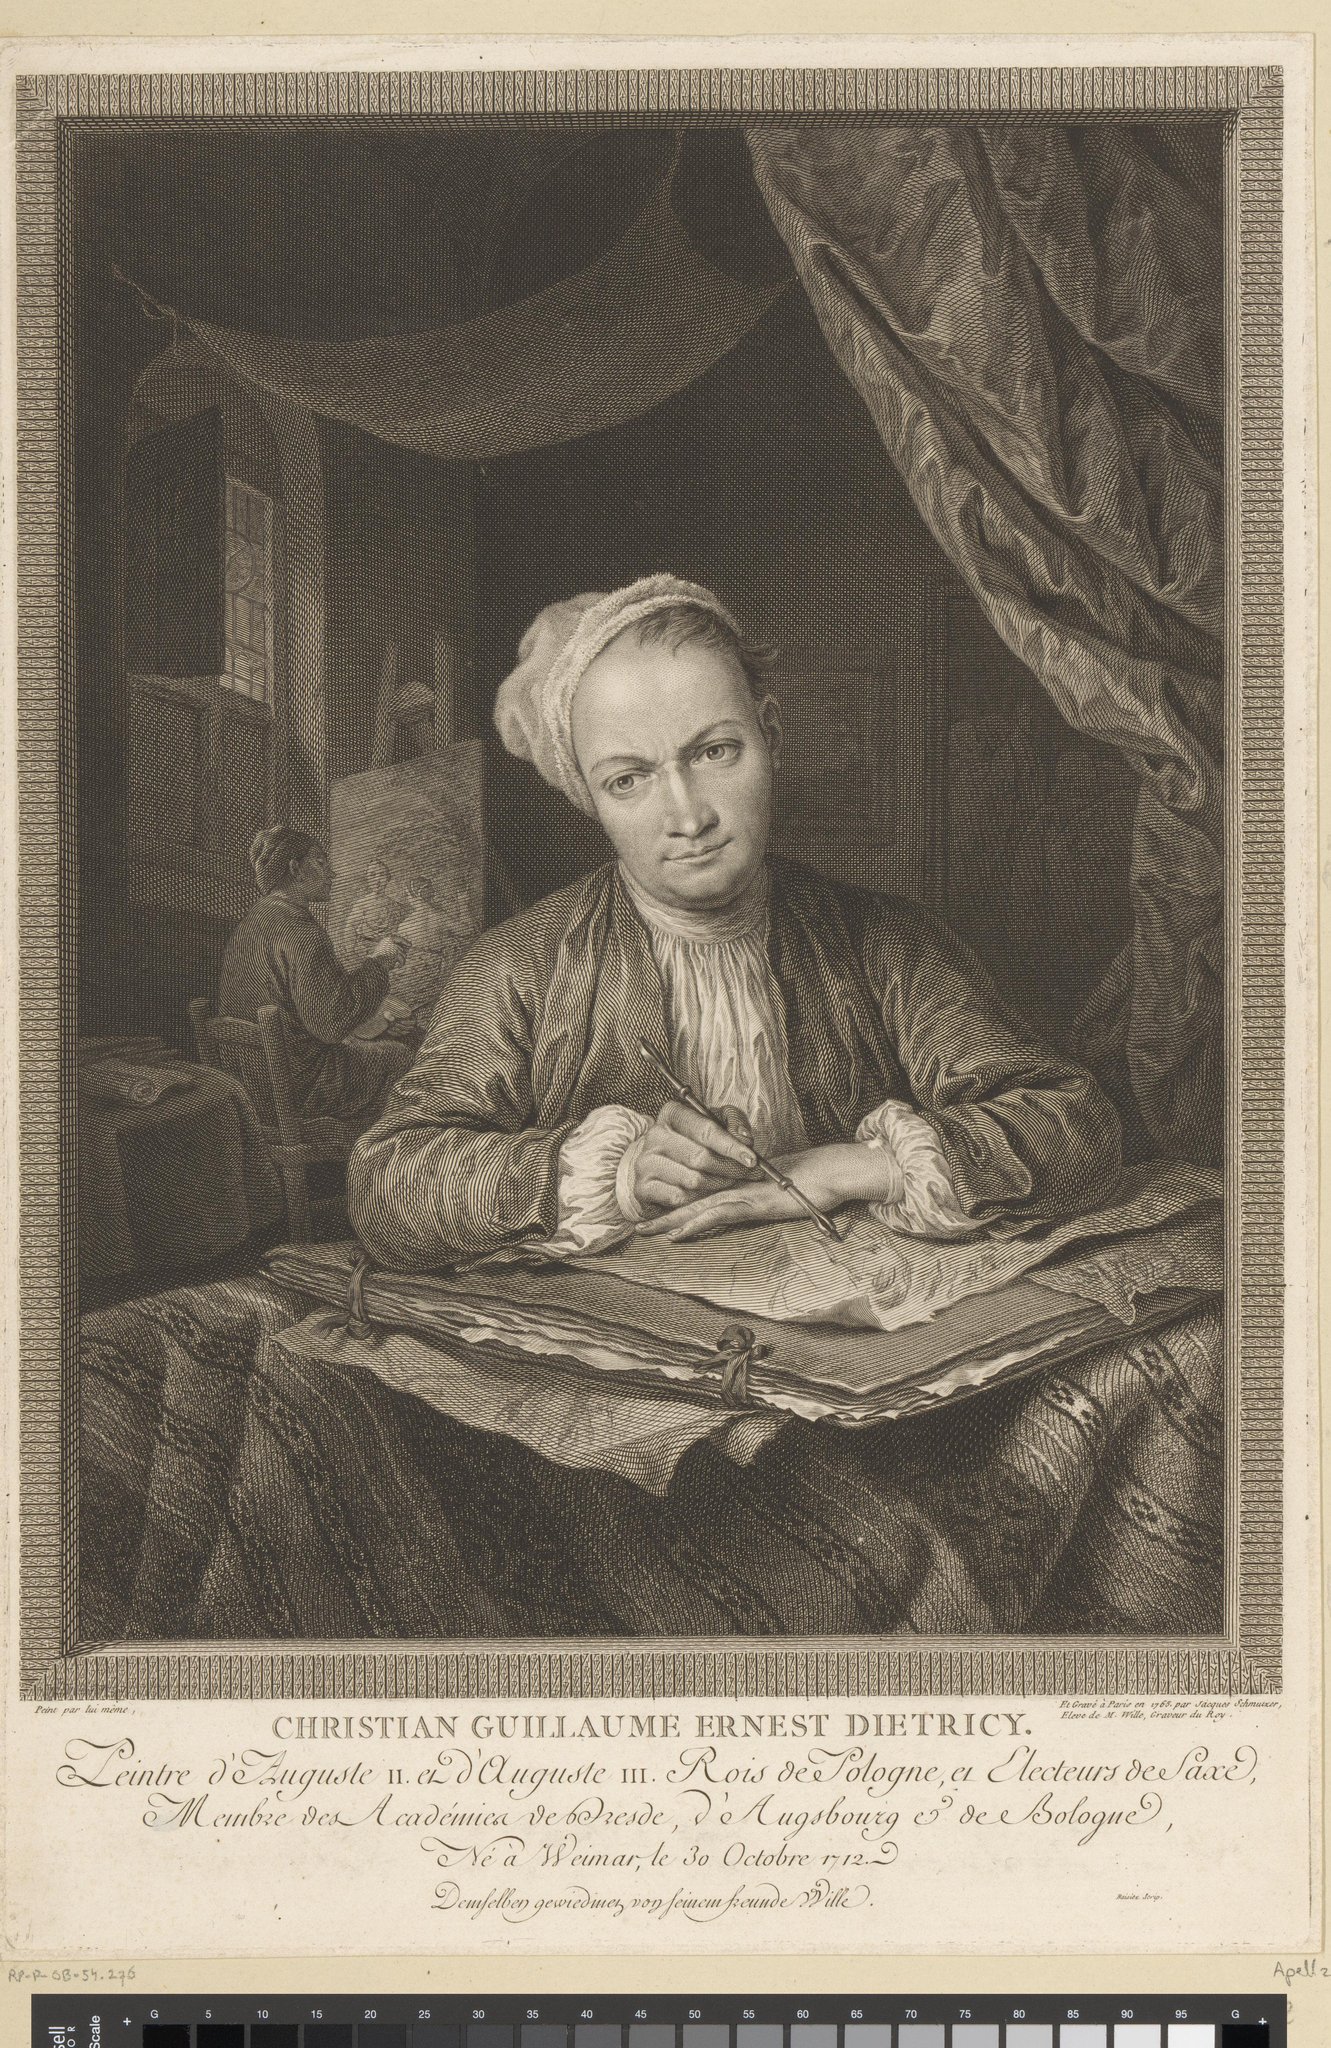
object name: print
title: Portret van Christian Wilhelm Ernst Dietrich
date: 1765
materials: paper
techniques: engraving, etching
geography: paris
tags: christian wilhelm ernst dietrich, historical persons, draughtsman at work, painter at work, in his studio, easel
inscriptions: collector's mark: Lugt 240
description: Portret van kunstenaar Christian Wilhelm Ernst Dietrich tekenend. In zijn rechterhand houdt hij een krijthouder, zijn linkerhand rust op de tekening. In de achtergrond een schilder voor een ezel.